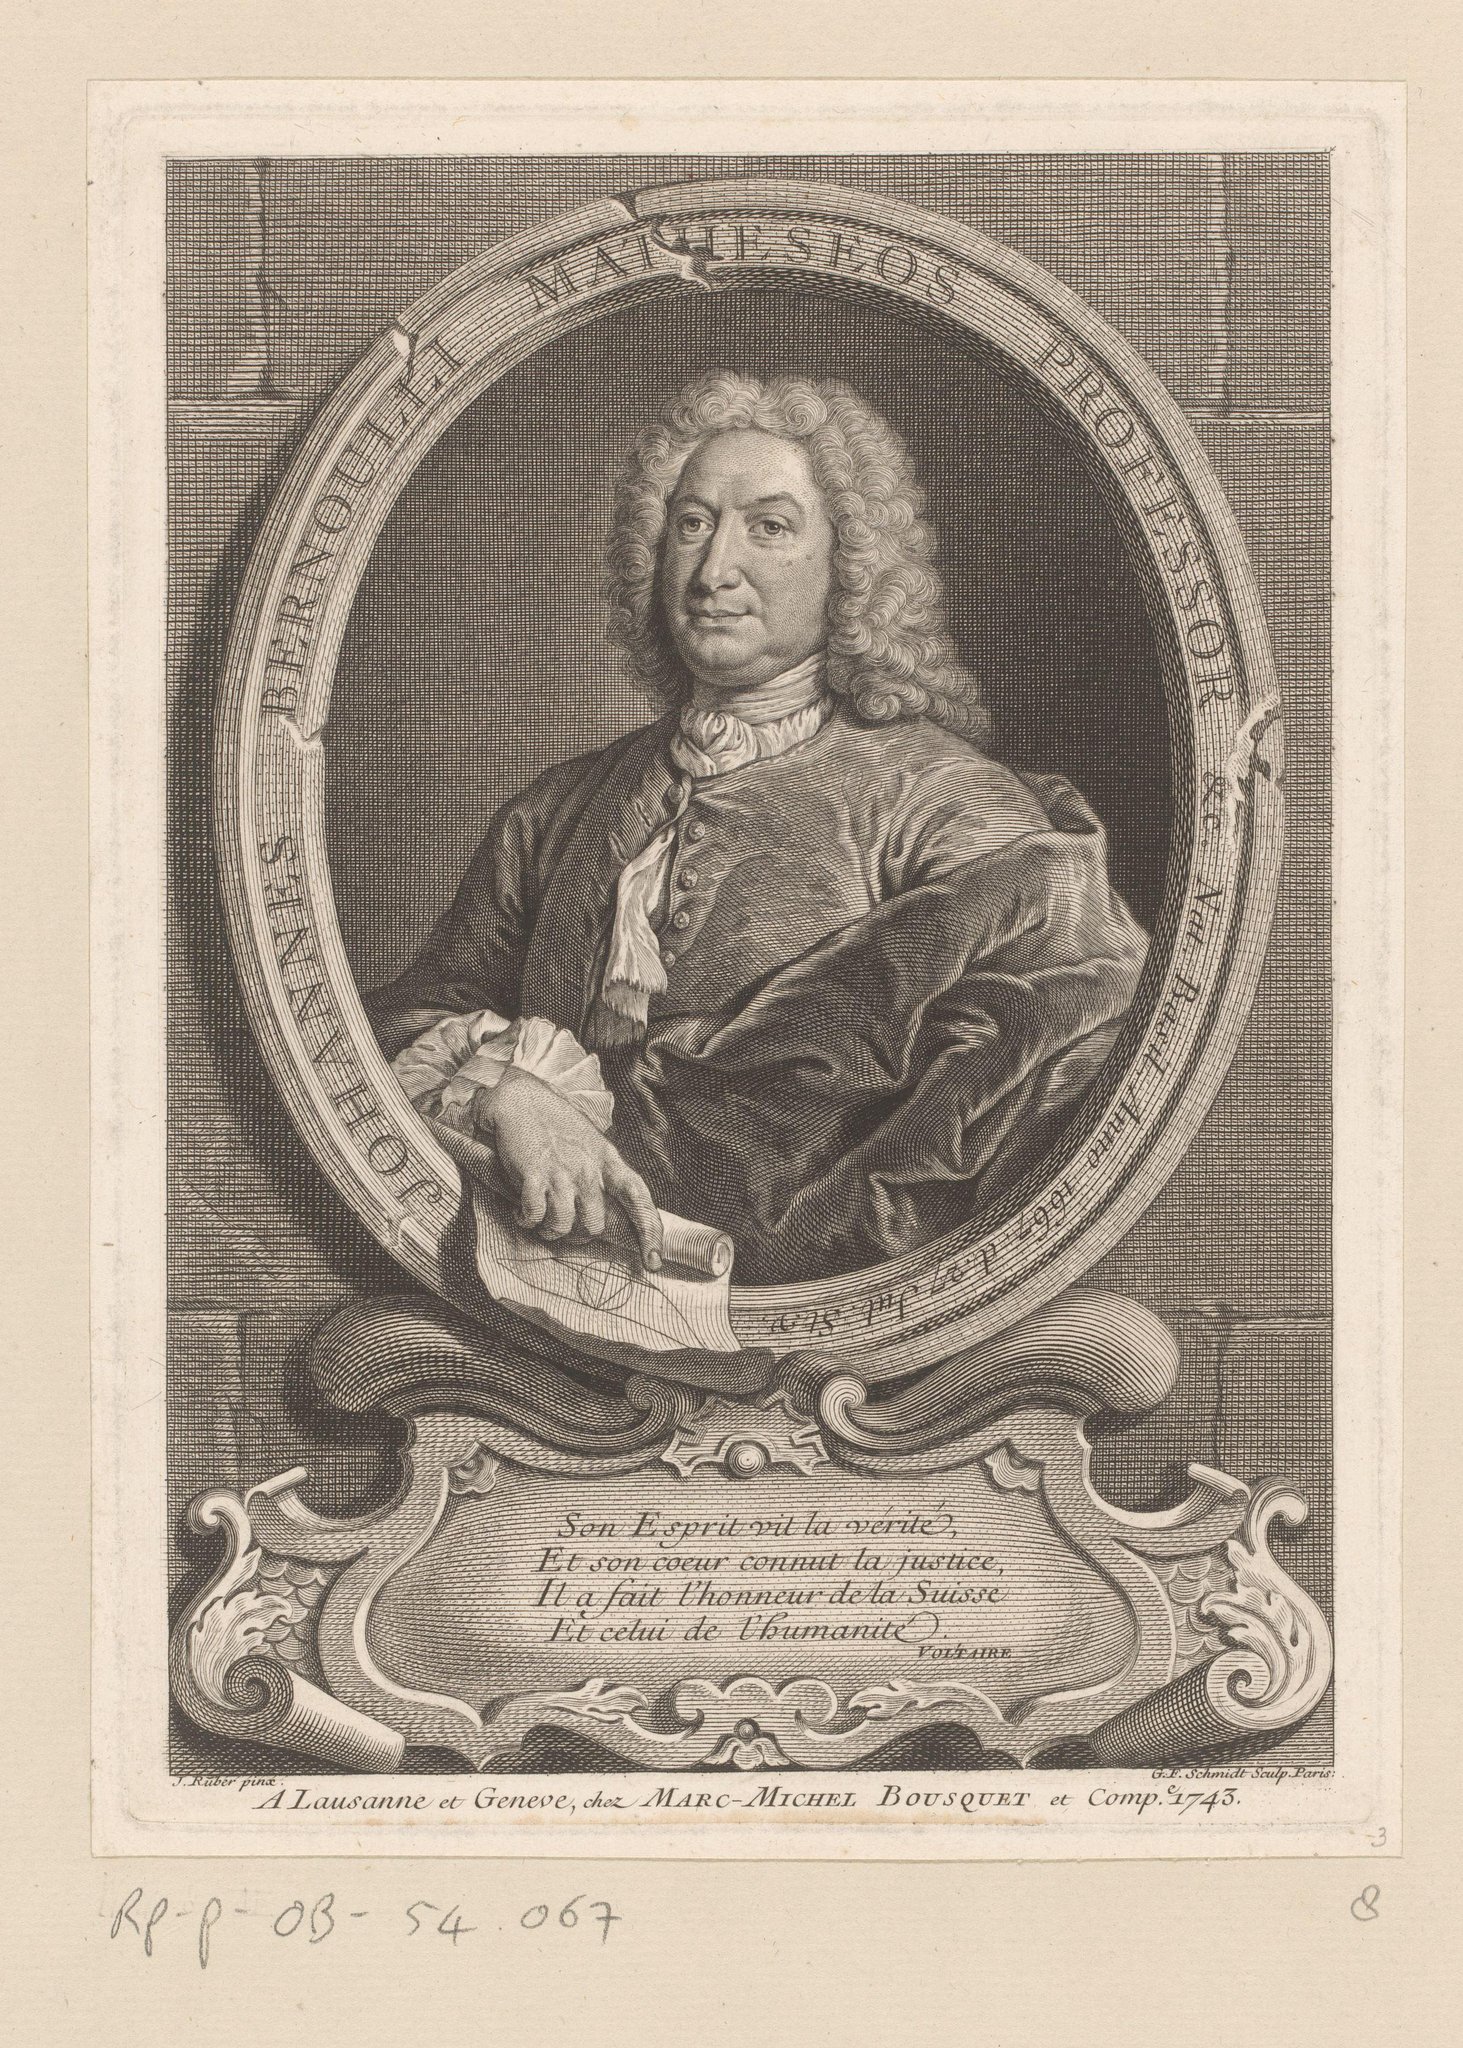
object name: print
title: Portret van Johann Bernoulli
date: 1743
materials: paper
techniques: engraving, etching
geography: geneva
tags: historical persons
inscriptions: collector's mark: Lugt 240